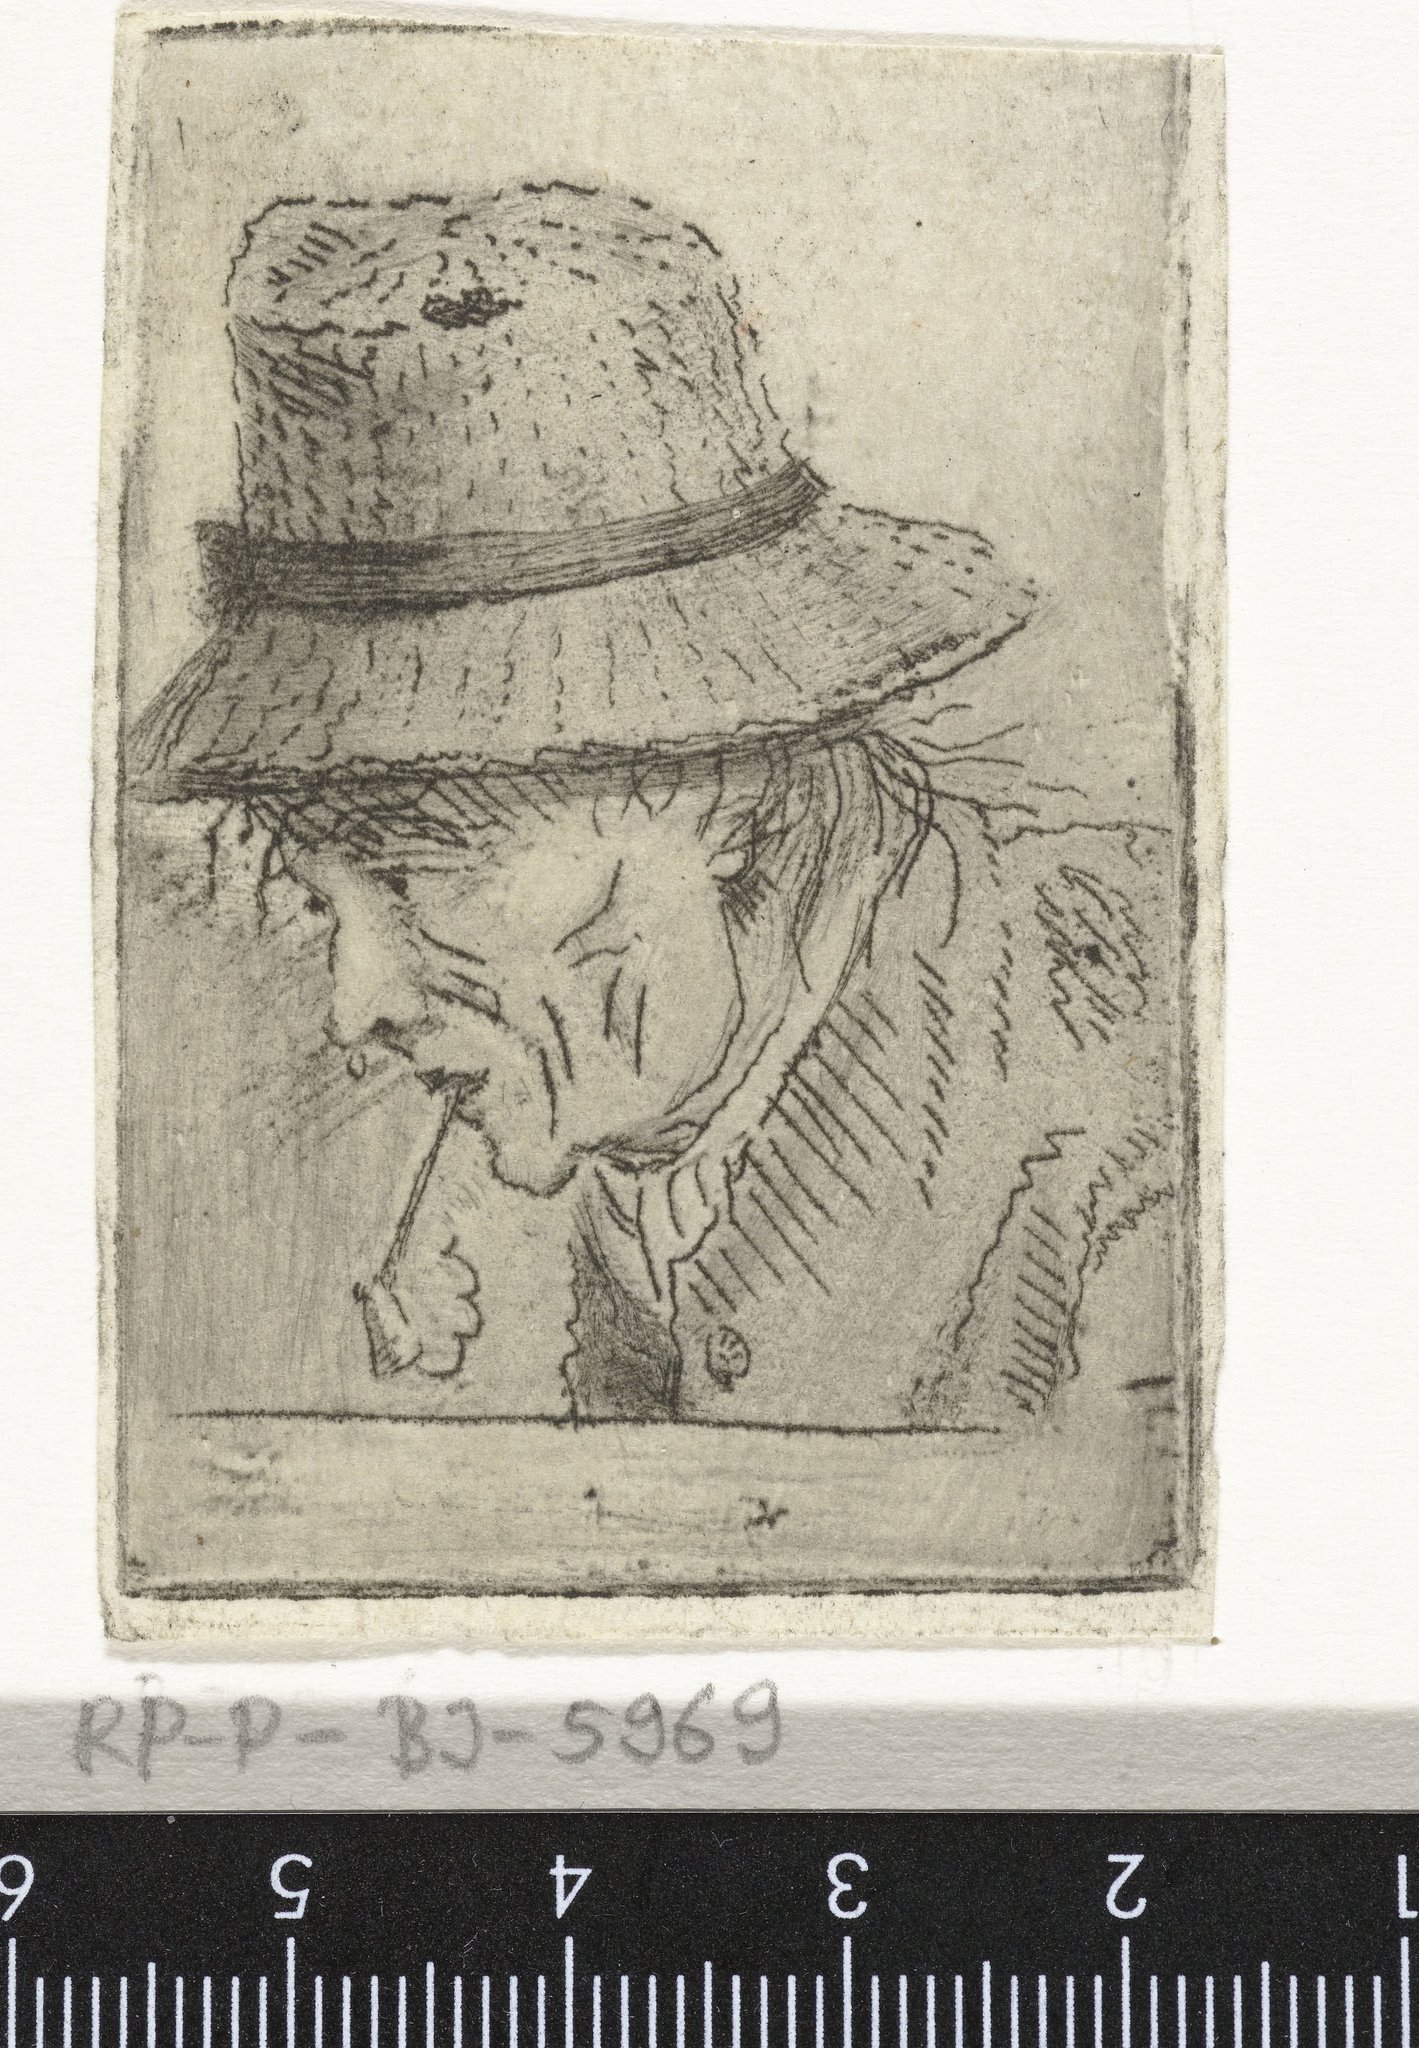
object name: print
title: Manshoofd met hoed en pijp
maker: louis bernard coclers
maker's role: draughtsman, print maker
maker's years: 1741-1817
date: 1756-1817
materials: paper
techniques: aquatint, drypoint, etching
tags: head-gear: hat (+ men's clothes), pipe ~ tobacco (+ taking (particular) foodstuffs: eating, drinking, smoking, chewing, etc.)